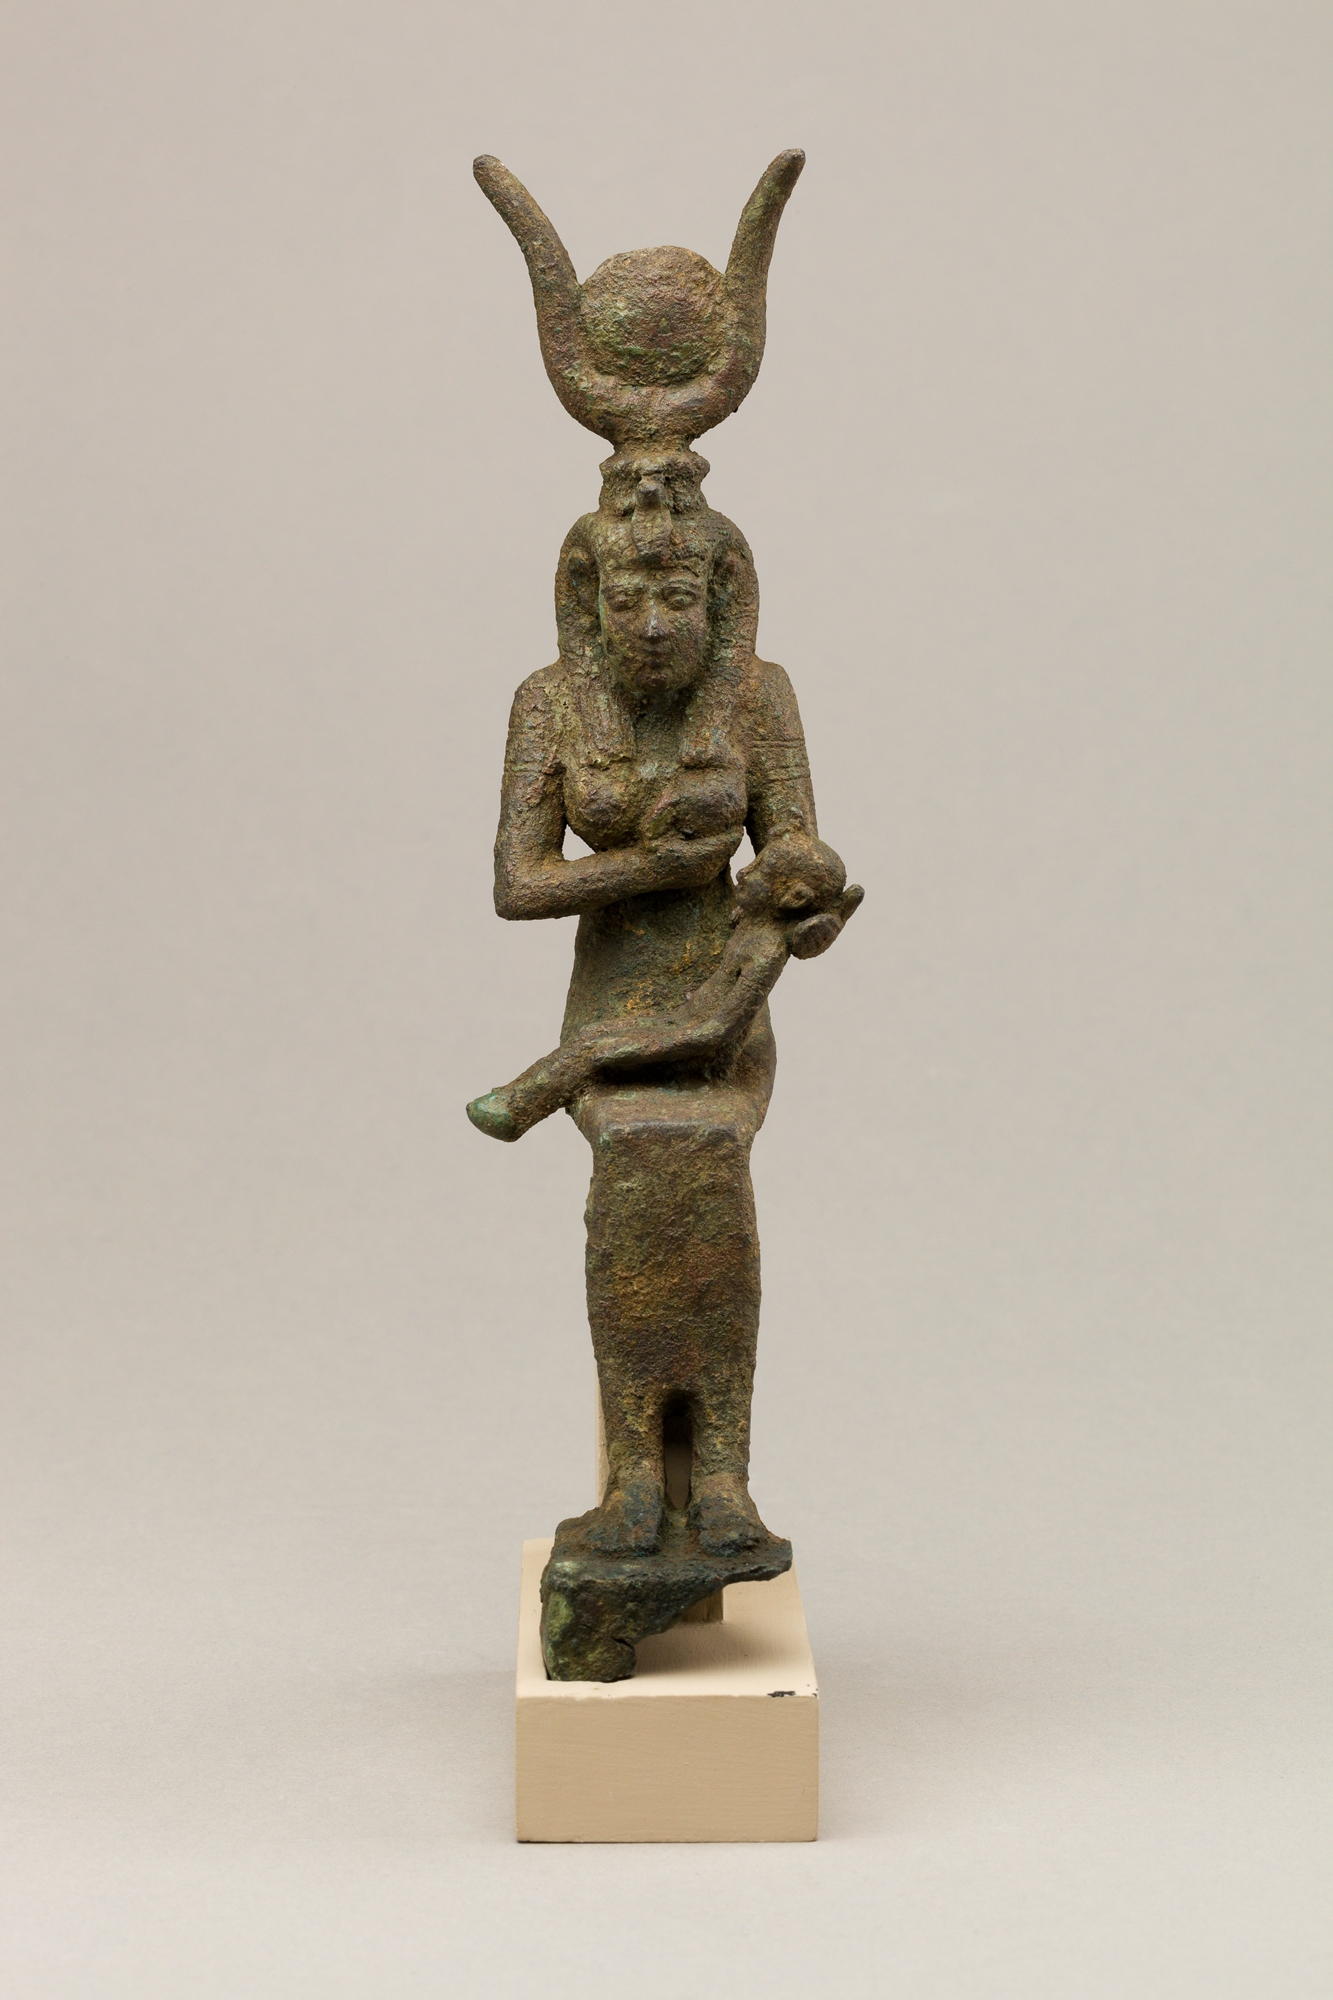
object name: statuette, isi, horus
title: Isis and Horus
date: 664-630 BCE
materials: metal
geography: egypt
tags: horus,isis,nursing